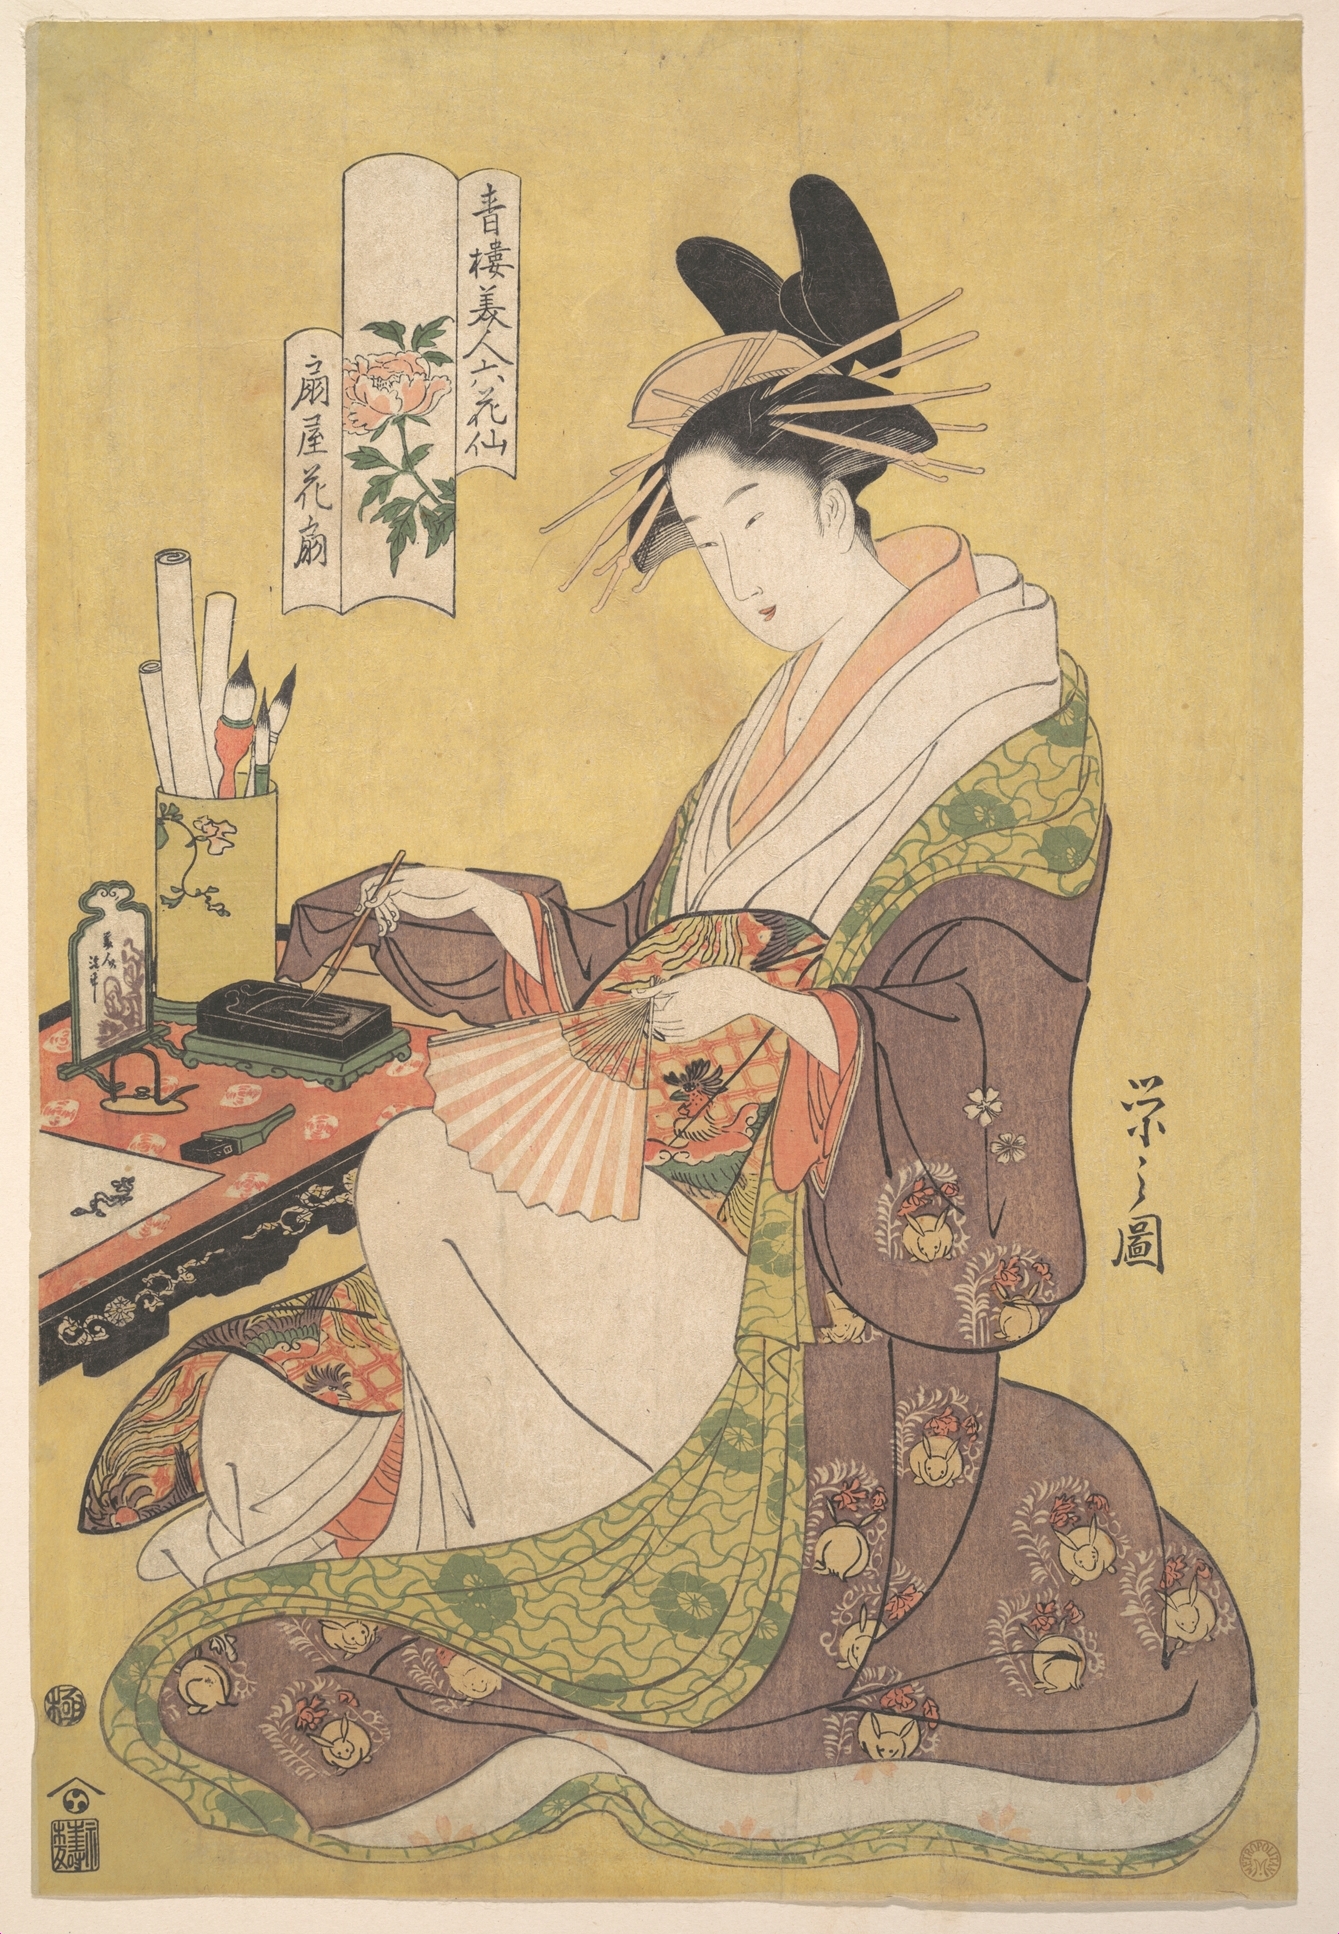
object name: woodblock print nishiki e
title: The Courtesan Hanaōgi of the Ōgiya Brothel (Ōgiya Hanaōgi), from the series Beauties of the Pleasure Quarters as Six Floral Immortals (Seirō bijin rokkasen)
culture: japanese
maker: chōbunsai eishi 鳥文斎栄之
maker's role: artist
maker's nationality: japanese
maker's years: 1756-1829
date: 1794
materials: ink, paper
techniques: nishiki e, woodblock print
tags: fans,women,working